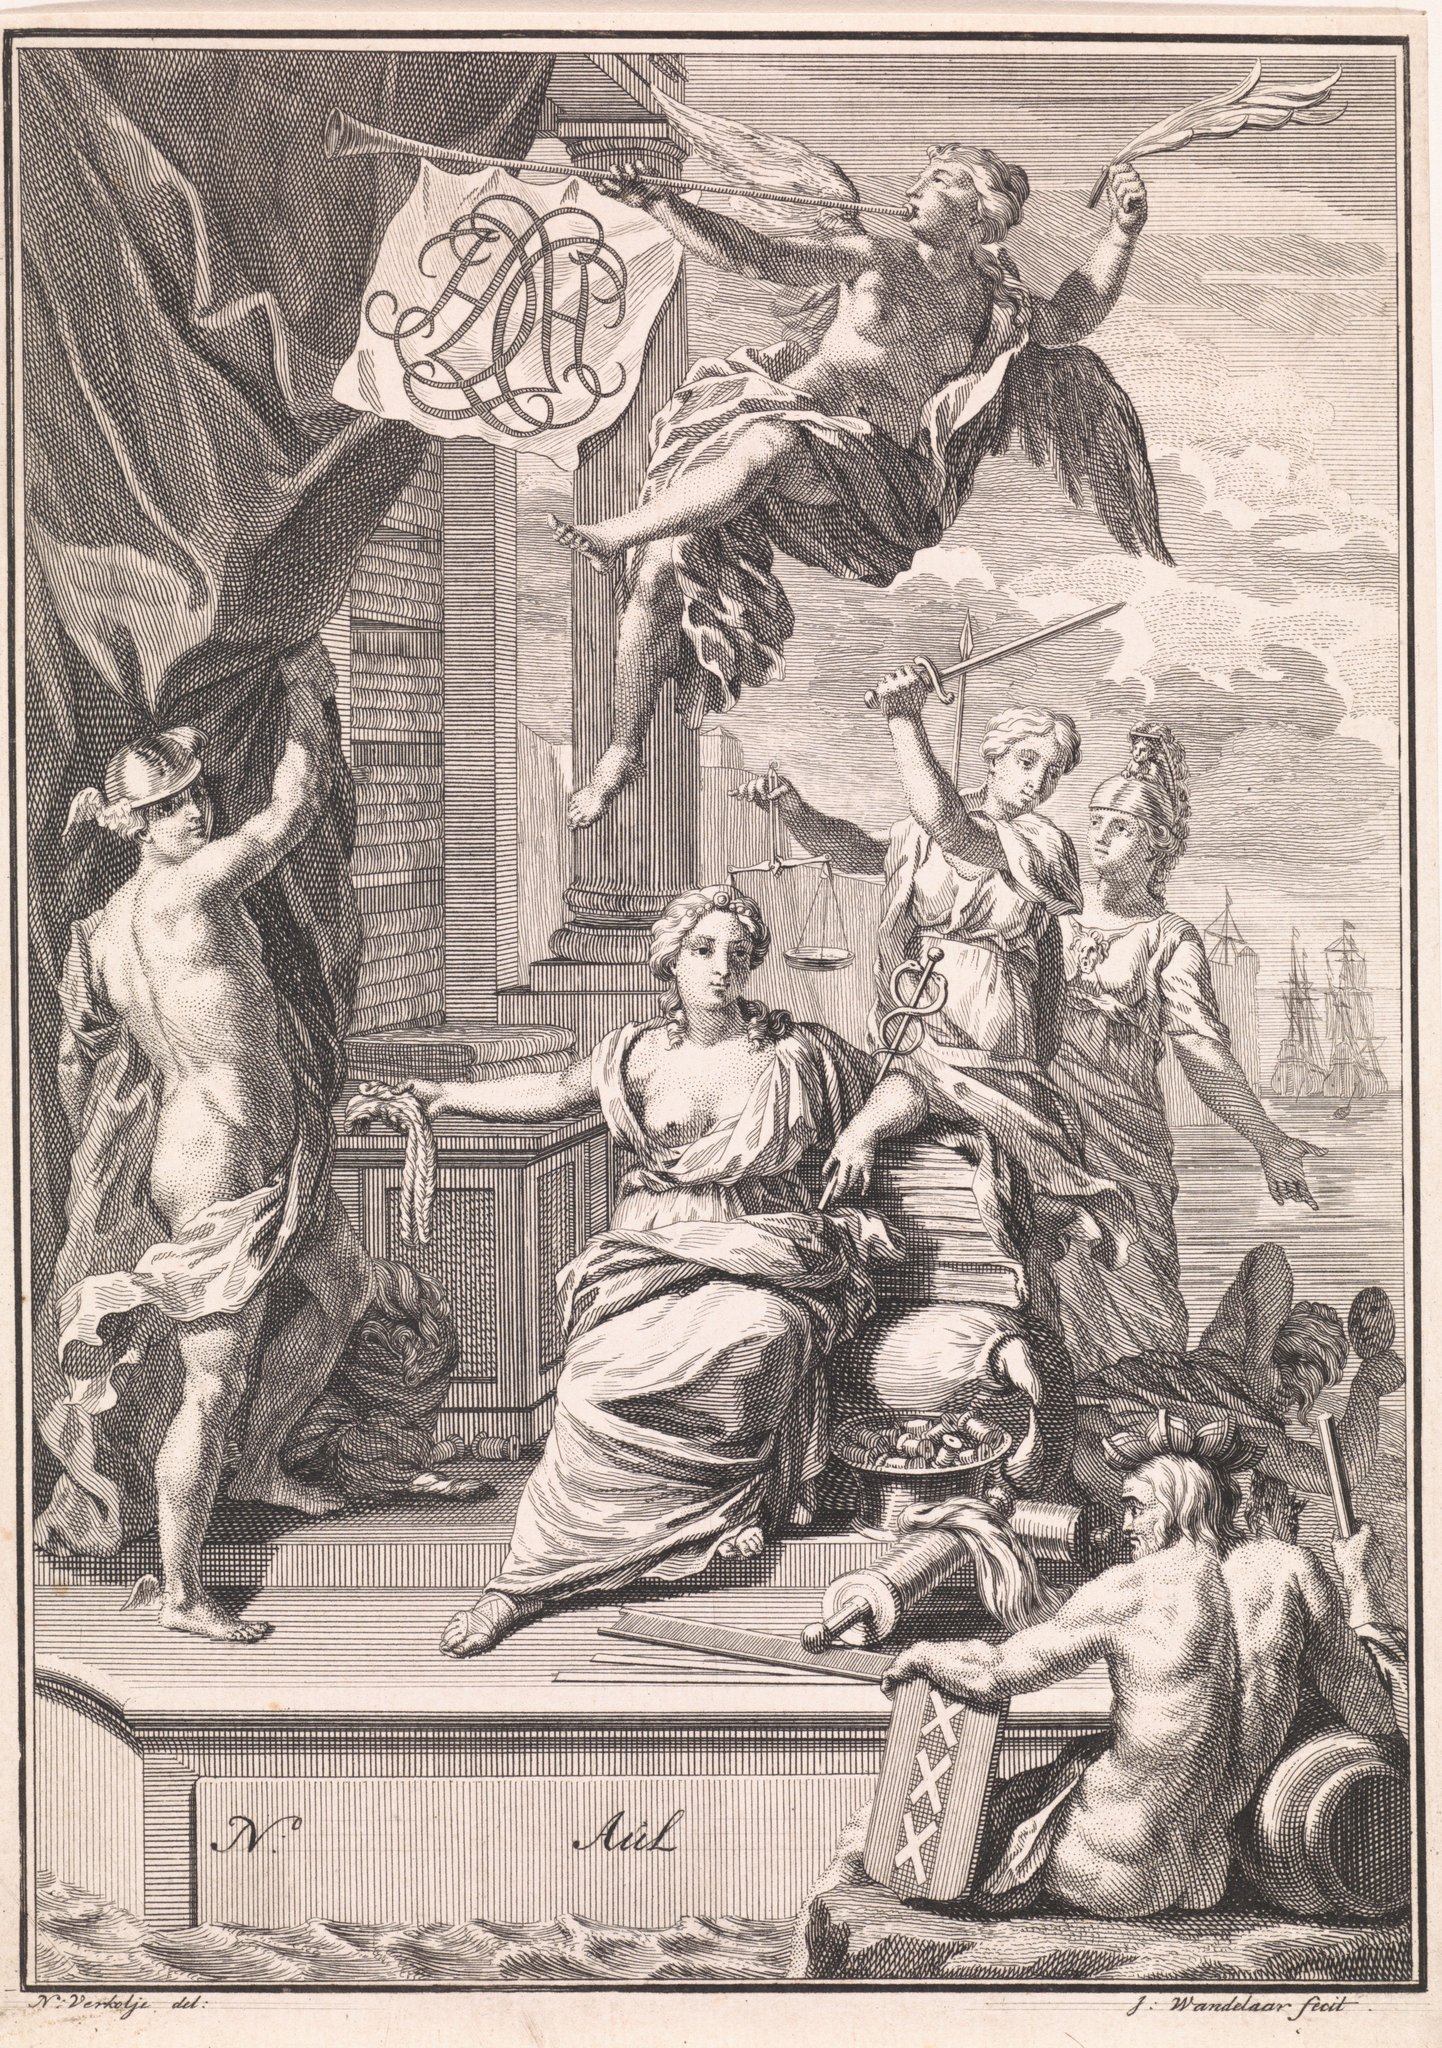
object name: handelsetiket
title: Handelsetiket van een lakenhandel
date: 1702-1759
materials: paper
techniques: engraving, etching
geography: northern netherlands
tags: justice, 'justitia'; 'giustitia divina' (ripa) ~ one of the four cardinal virtues, (story of) mercury (hermes), river-gods, specific aspects, allegorical aspects of minerva; minerva as patroness, fame; 'fama', 'fama buona', 'fama chiara' (ripa), allegory of trade; 'commertio della vita humana' (ripa), textile industry and clothing industry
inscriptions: collector's mark: Lugt 240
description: Op een verhoging zit de personificatie van de Handel, te midden van klosjes garen. Achter haar Rechtvaardigheid en Minerva. Ter linkerzijde staat Mercurius, de god van de handel, die een draperie opzij schuift om een winkel te onthullen. In de lucht vliegt Faam, aan haar bazuin een vaandel waarop een monogram met initialen [van de handelaar]. Op de voorgrond zit een riviergod met het wapenschild van de stad Amsterdam onder zijn arm.